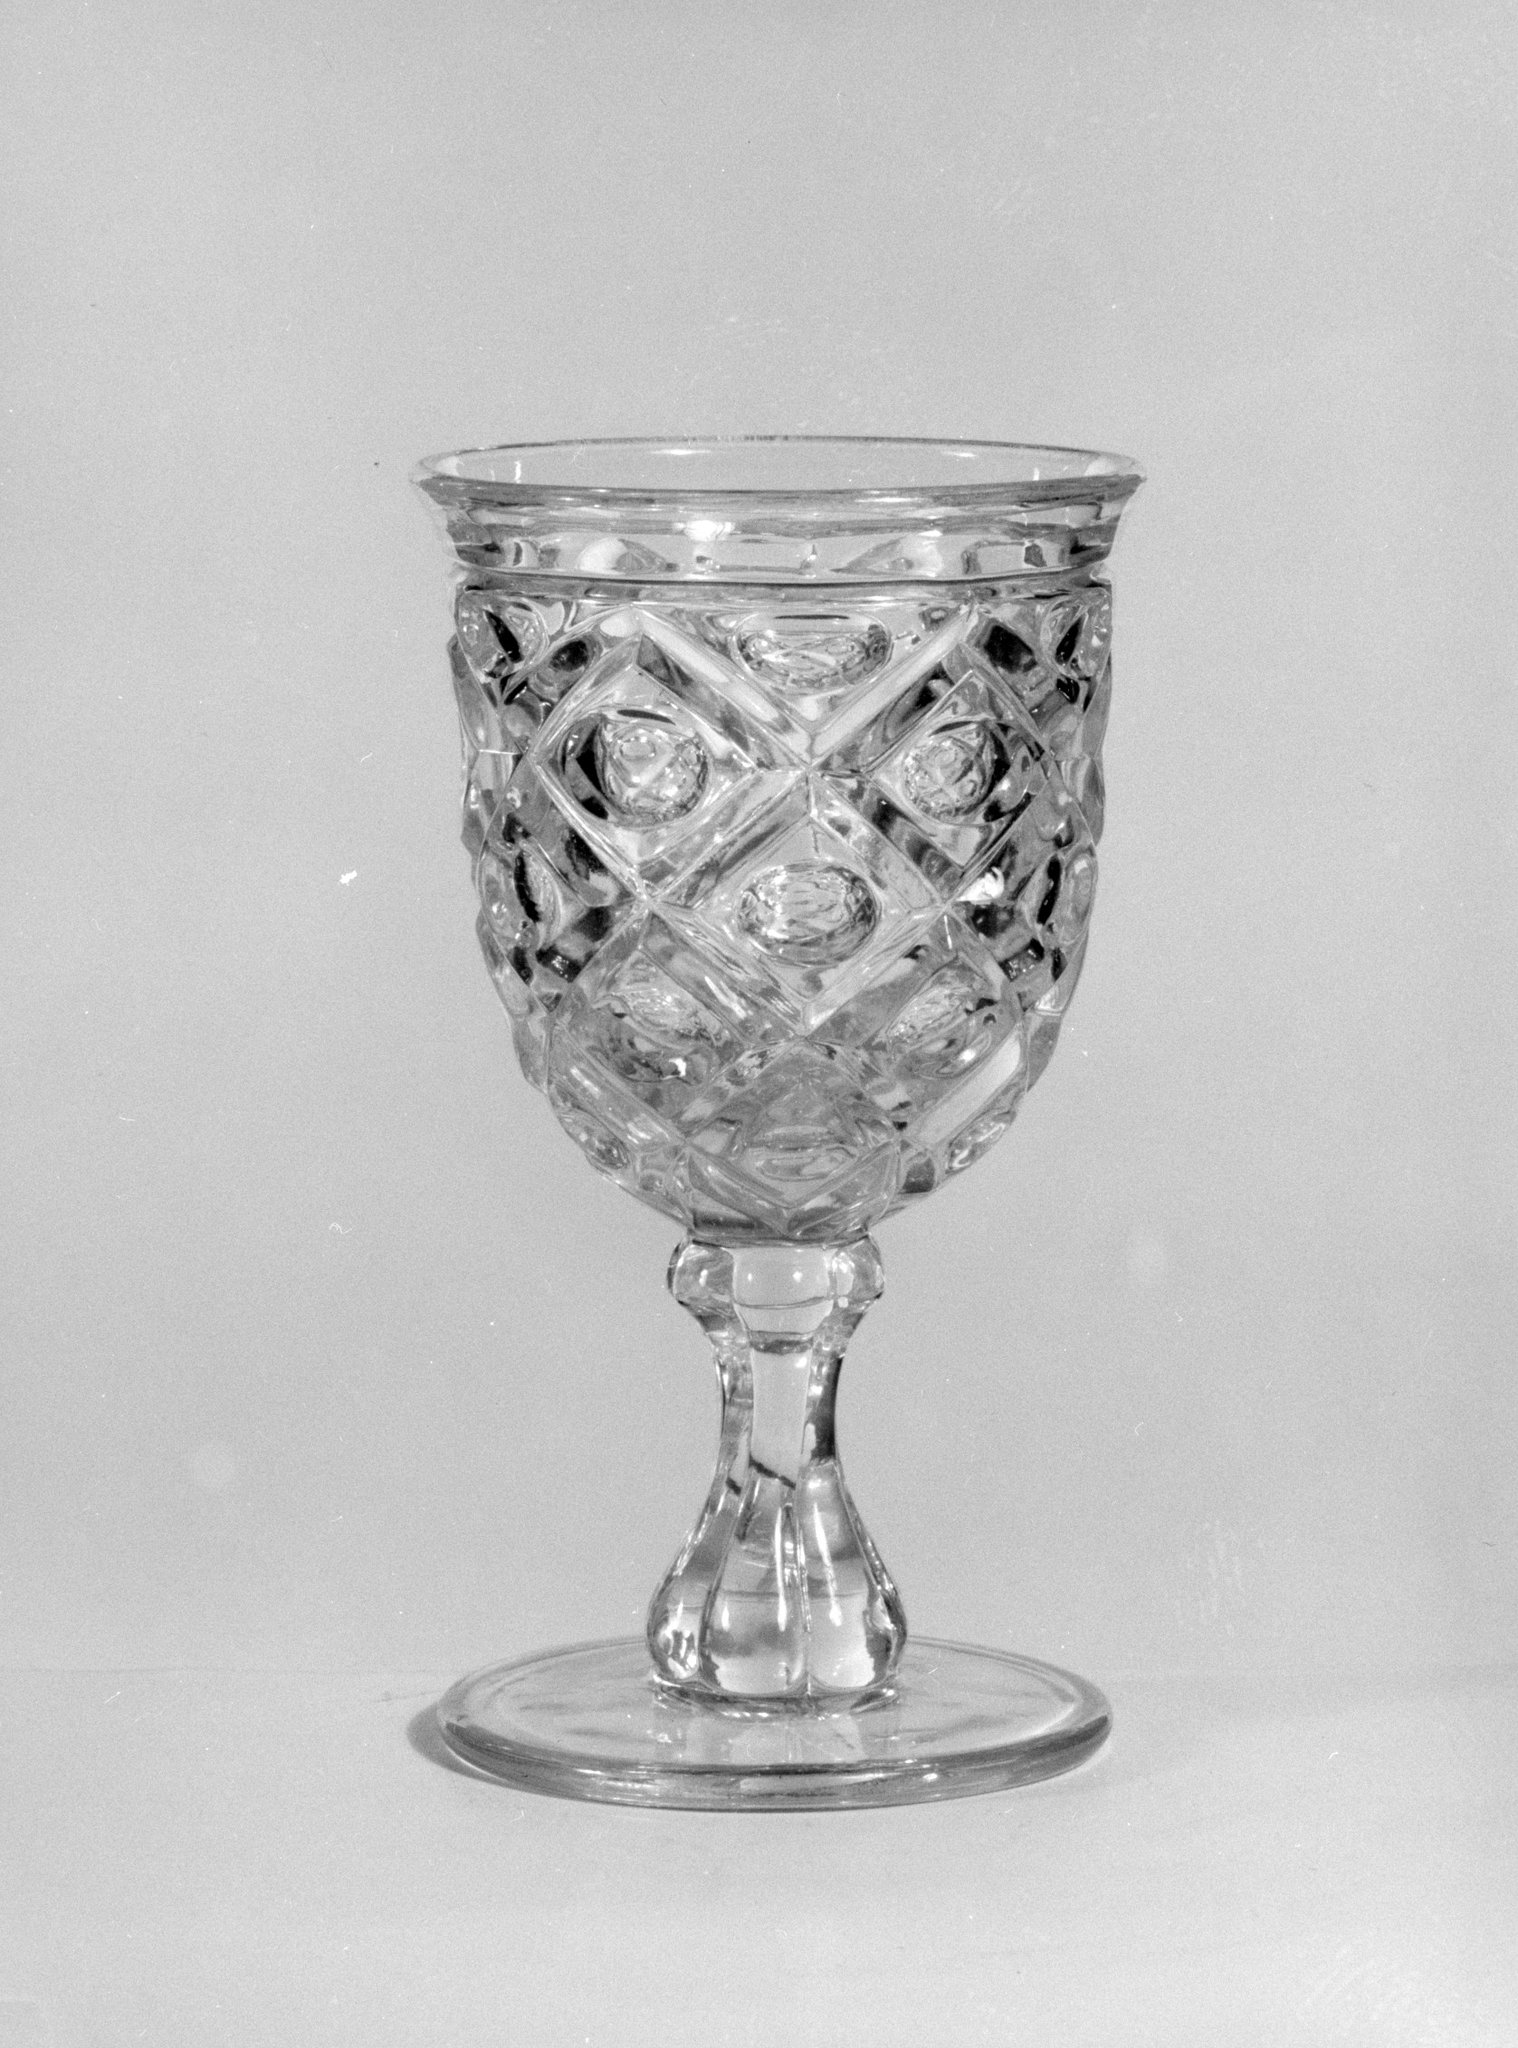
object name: goblet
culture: american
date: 1850-1860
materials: diamond, glass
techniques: pressed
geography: united states